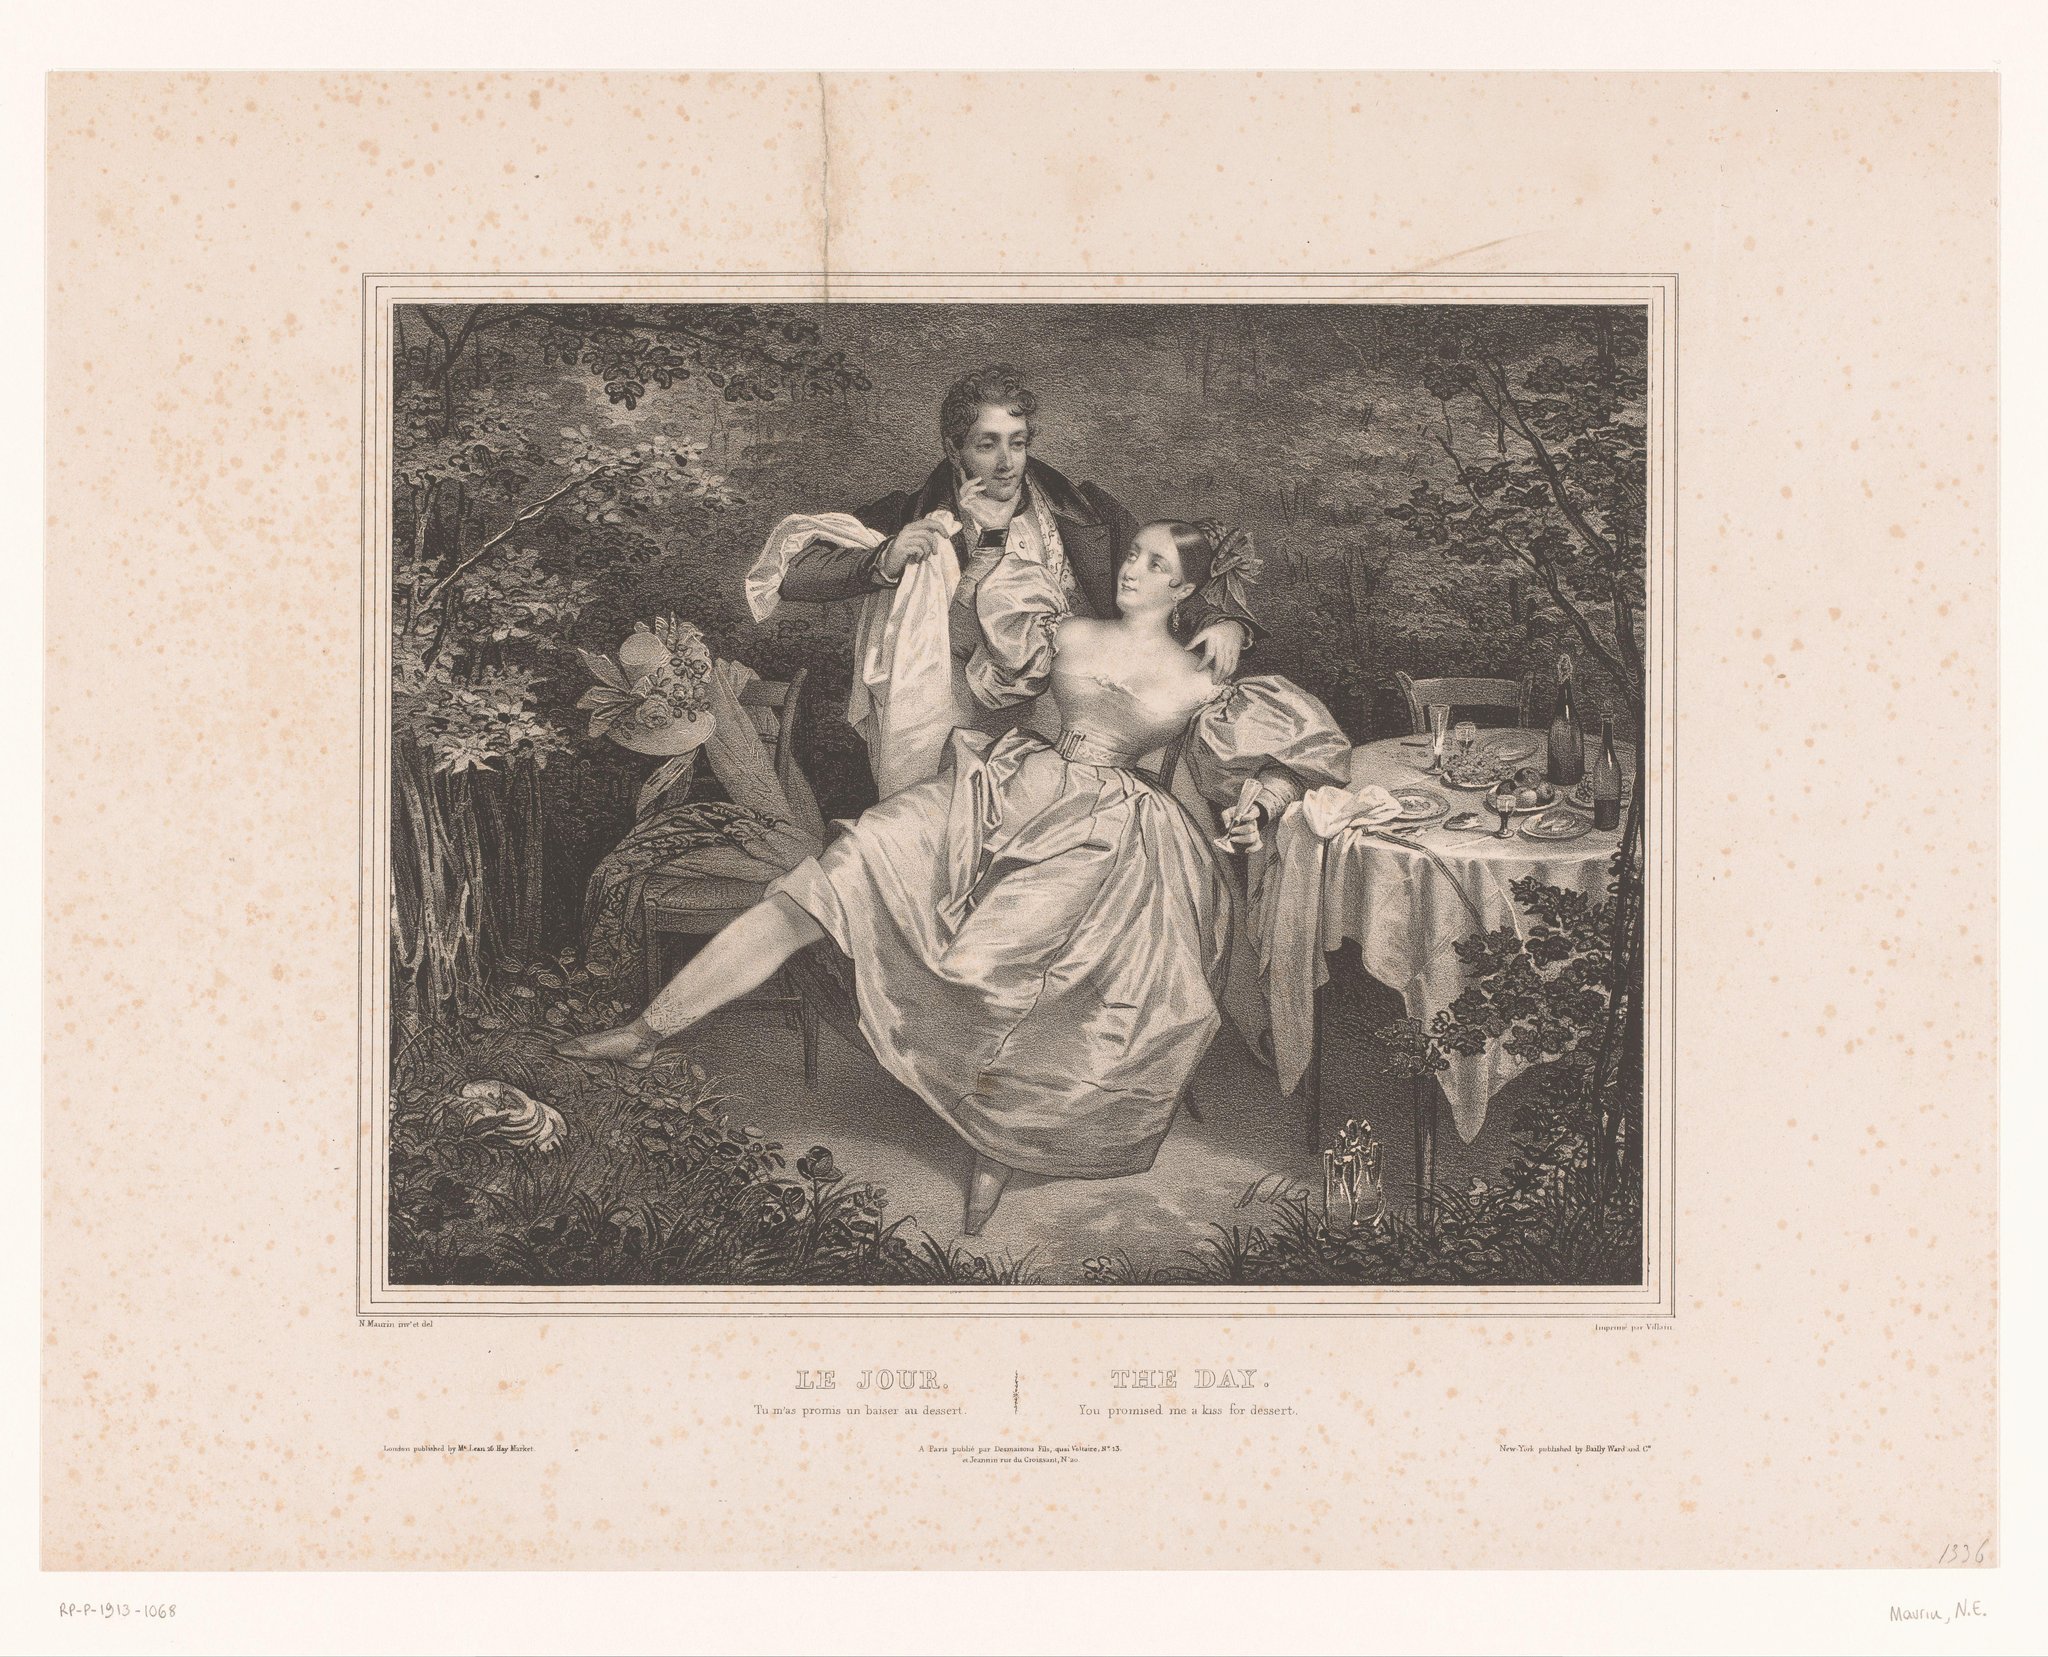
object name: print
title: Romantische lunch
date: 1830-1837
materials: paper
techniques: lithograph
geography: paris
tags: midday meal, lunch - cc - out of doors, lovers' meeting, afternoon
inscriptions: collector's mark: Lugt 2228, check stamp: ‘ED’